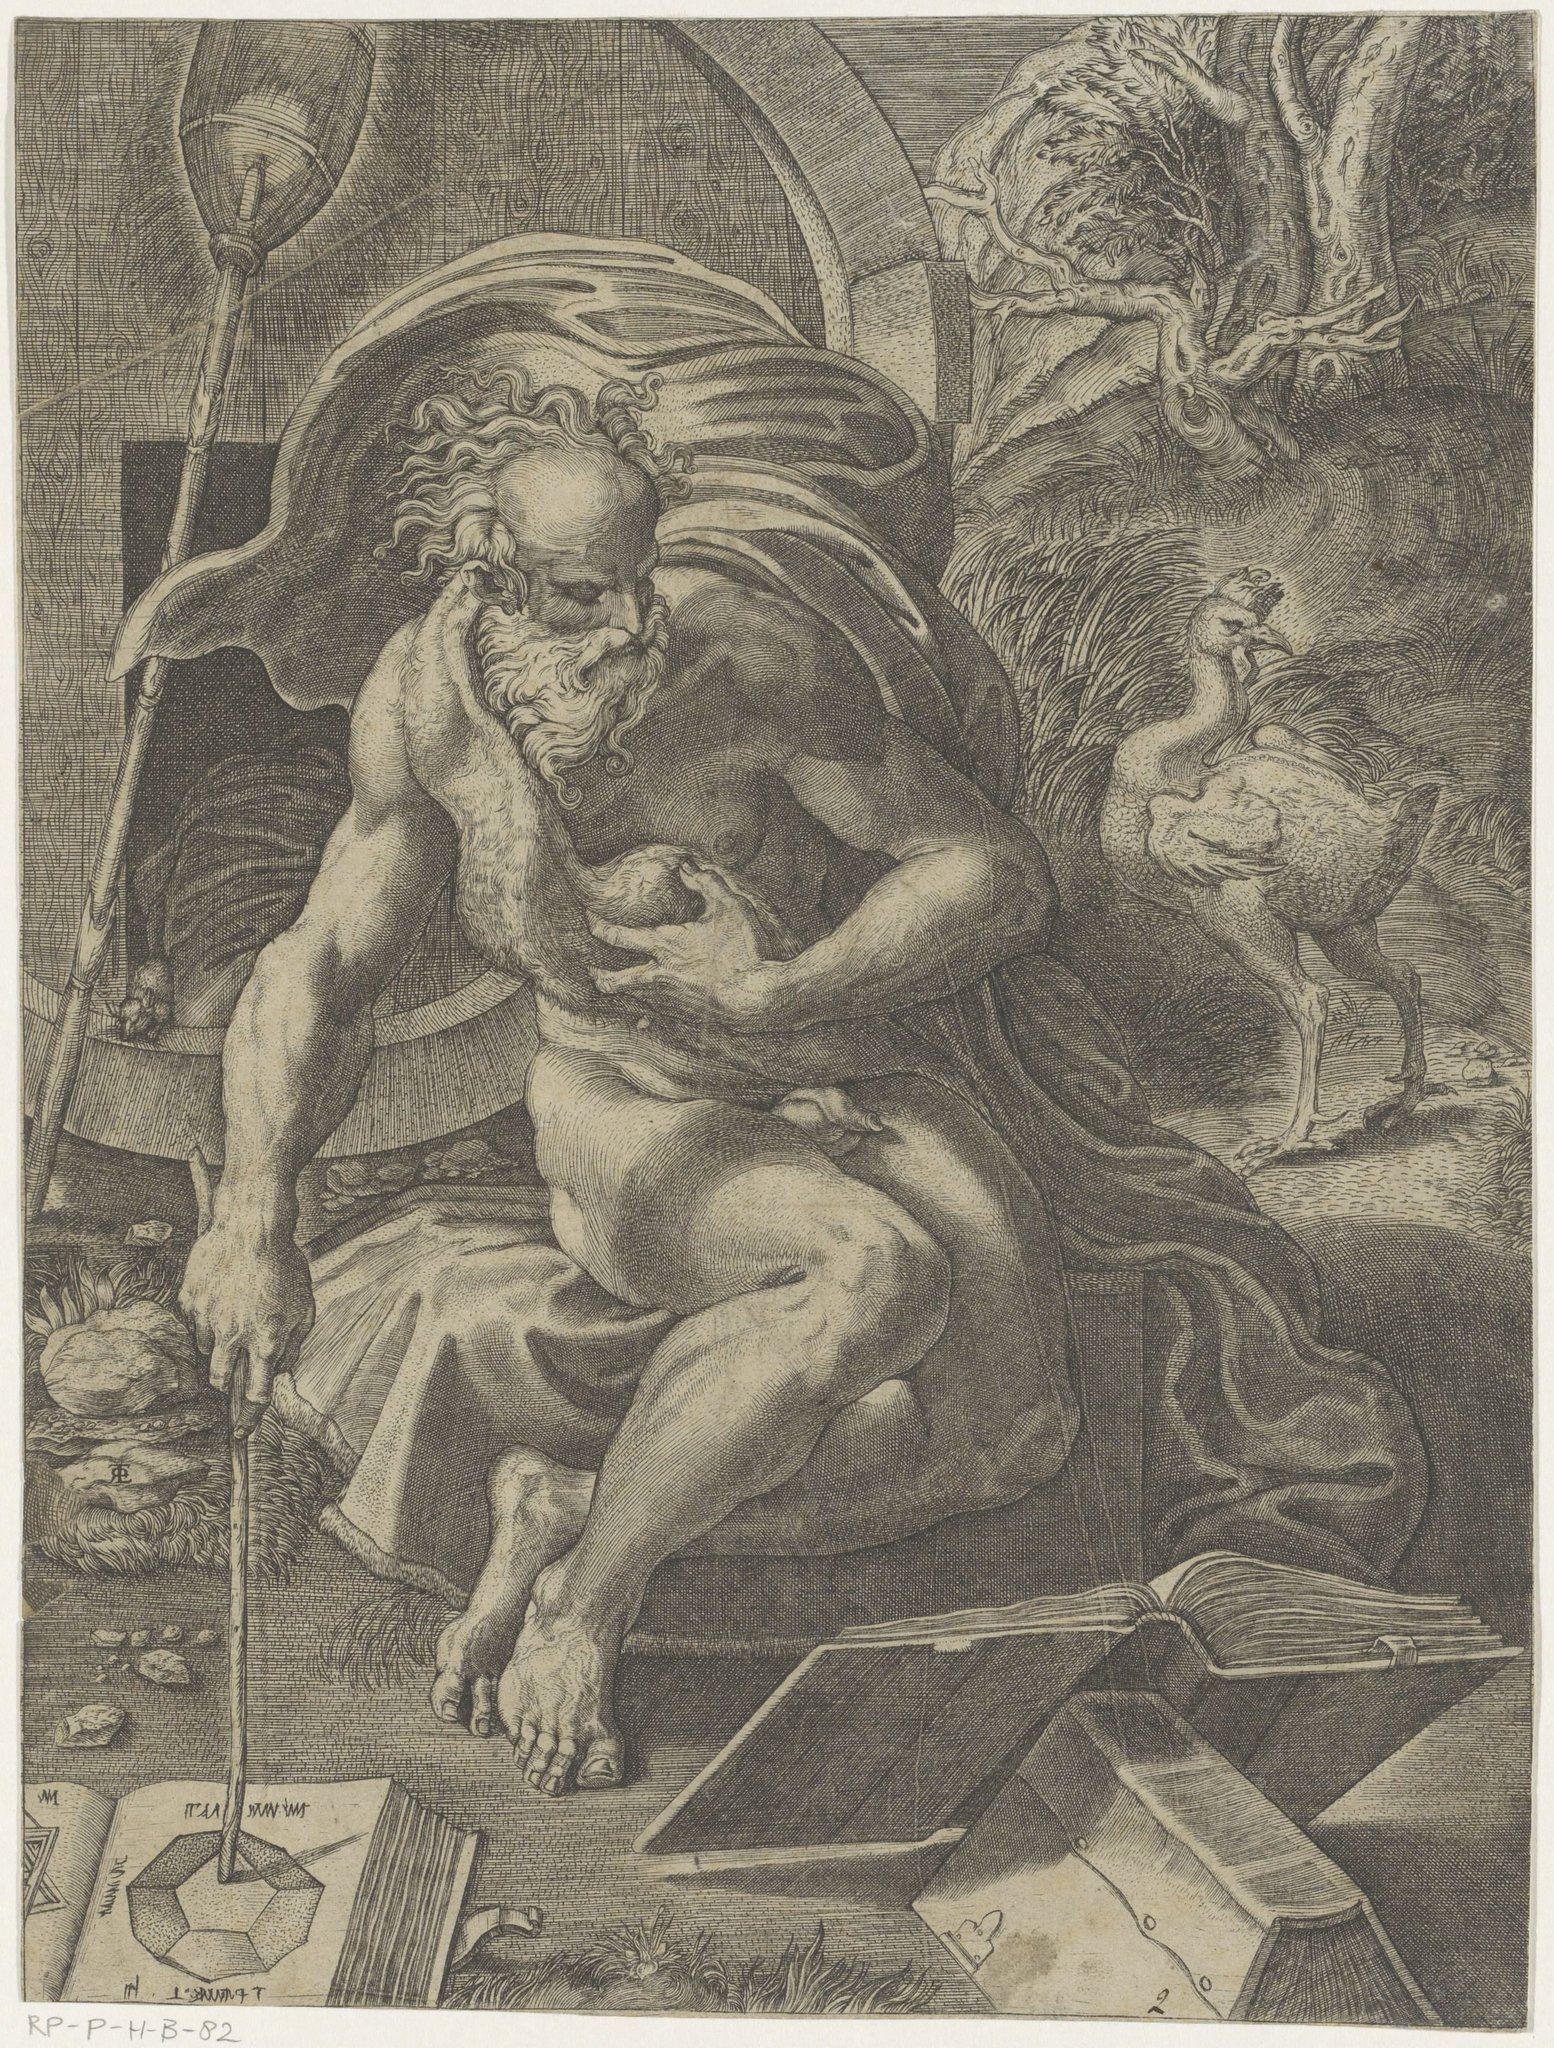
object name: print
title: Diogenes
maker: giovanni jacopo caraglio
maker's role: goldsmith, print maker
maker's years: 1500-1565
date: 1515-1565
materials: paper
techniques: engraving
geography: italy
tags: diogenes mocks plato's definition of man, by showing a plucked fowl, (story of) diogenes, the philosopher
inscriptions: collector's mark: Lugt 11, collector's mark: Lugt 10, number: ‘2’, collector's mark: ‘Hinloopen’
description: Diogenes zit op de grond voor zijn vat. In zijn hand heeft hij een stok waarmee hij in een geometrieboek wijst. Op de achtergrond rechts een geplukte haan.